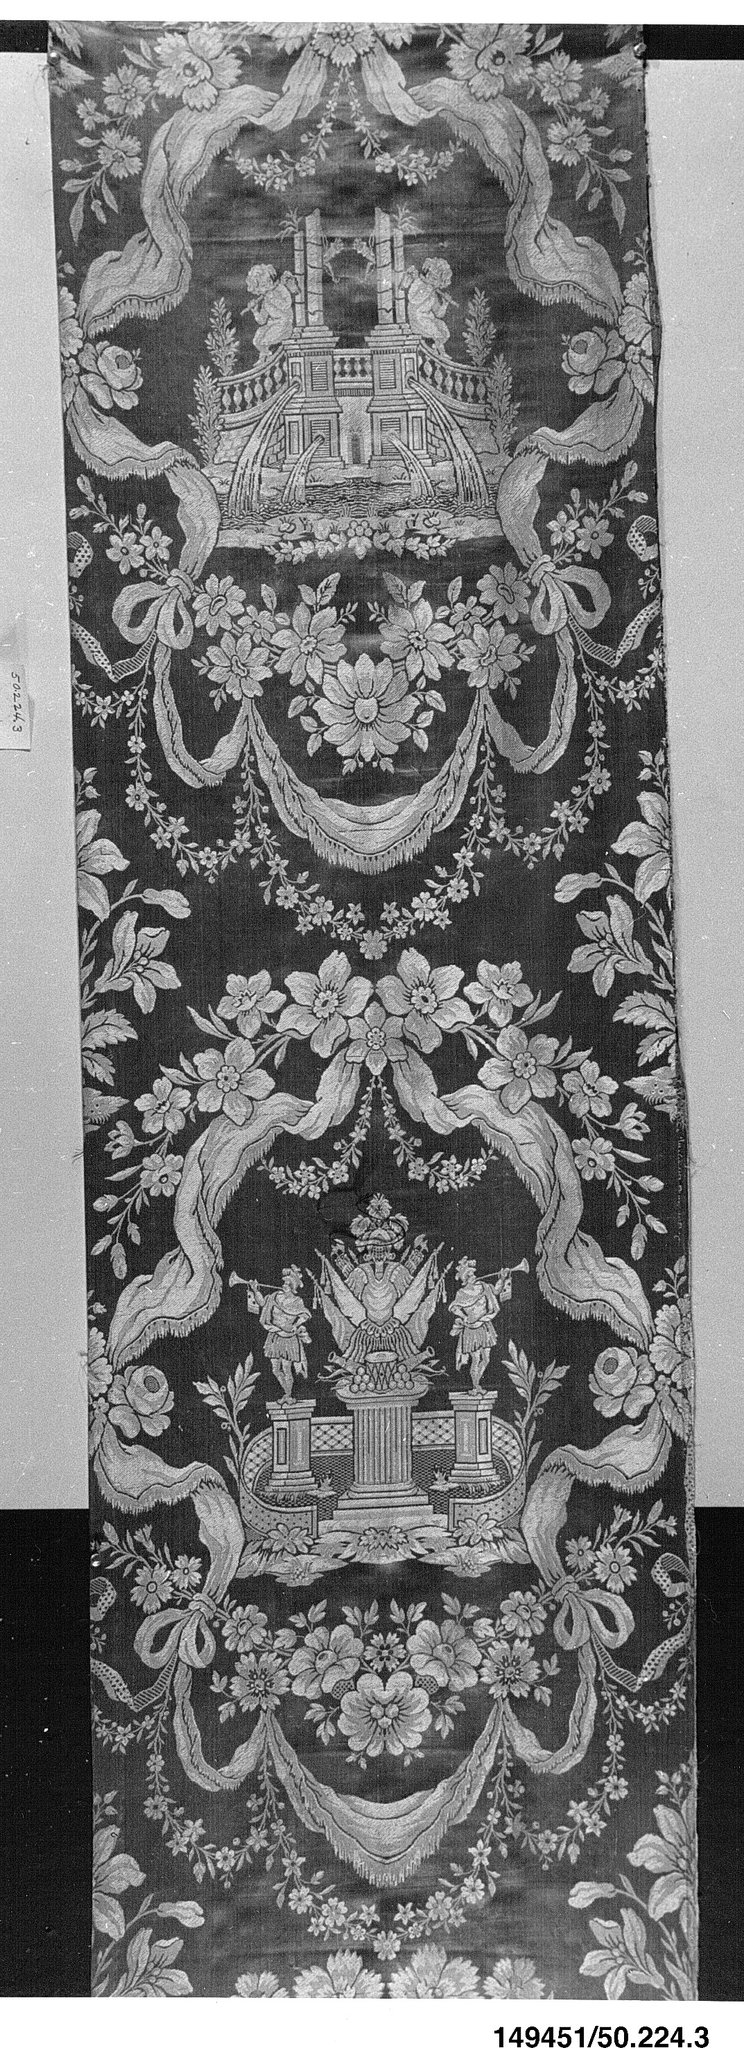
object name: piece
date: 1780-1790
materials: silk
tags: men,flowers